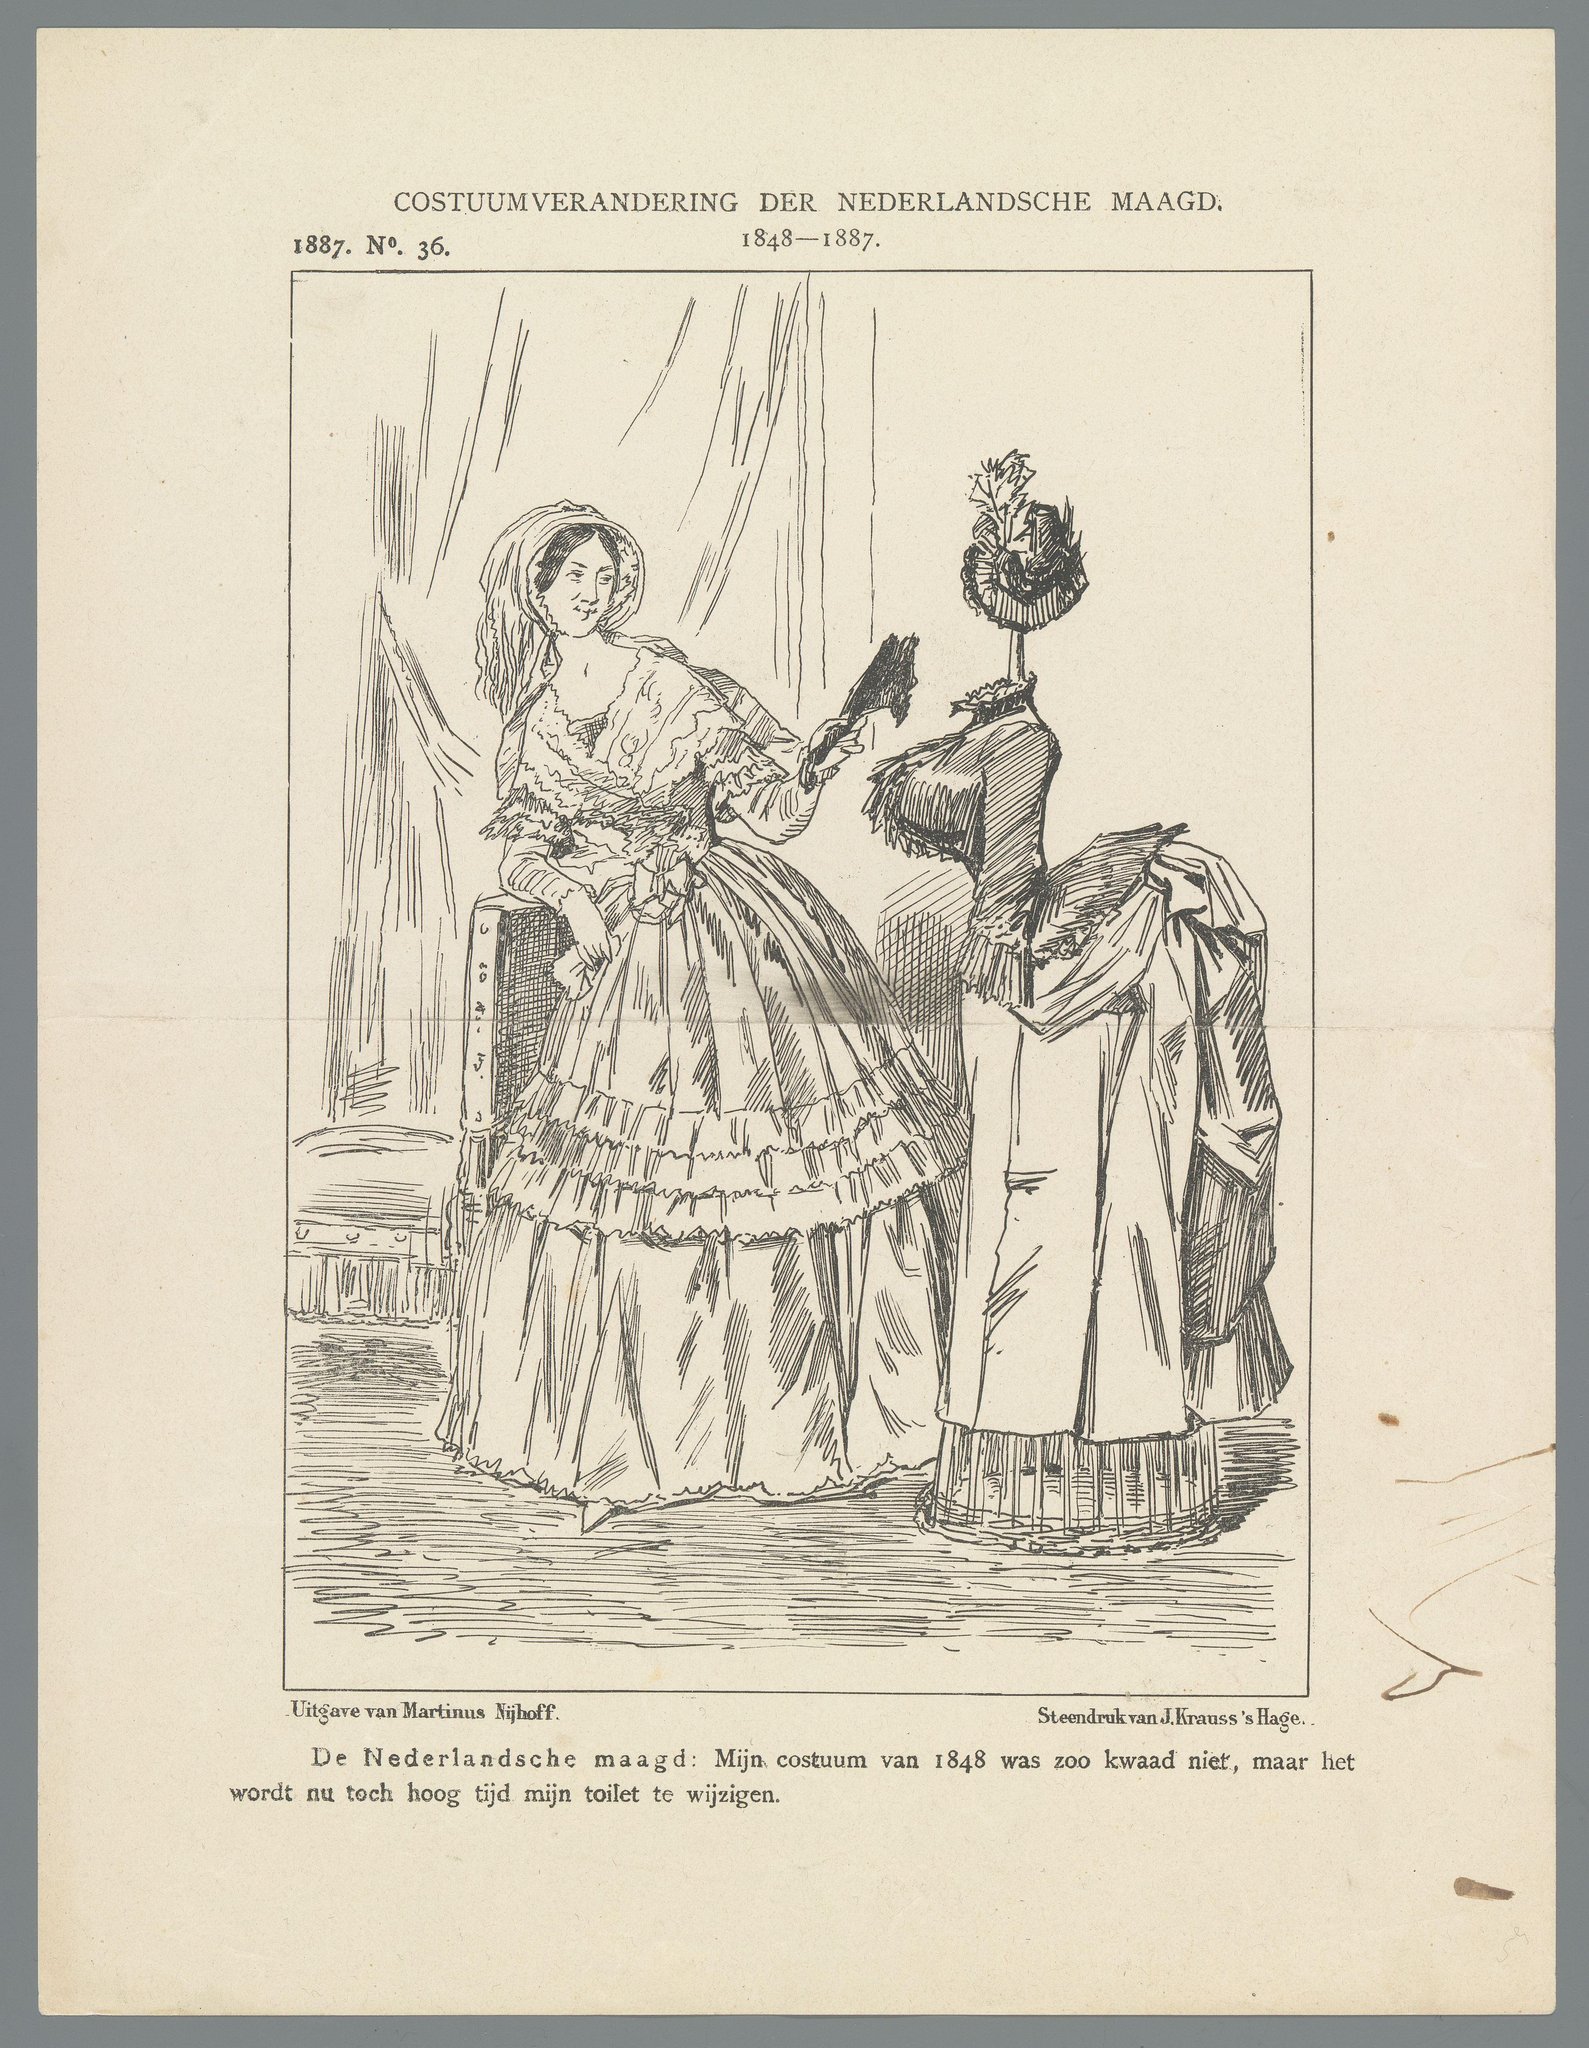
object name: cartoon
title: Spotprent over de grondwetsherziening, 1887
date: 1887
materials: paper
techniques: lithograph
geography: the hague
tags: personifications of countries, nations, states, districts, etc.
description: Spotprent over de grondwetsherziening: de Nederlandse Maagd verruilt haar oude kostuum uit 1848 voor een modernere dracht. Plaat verschenen bij het weekblad De Nederlandsche Spectator, nr. 36, 1887.